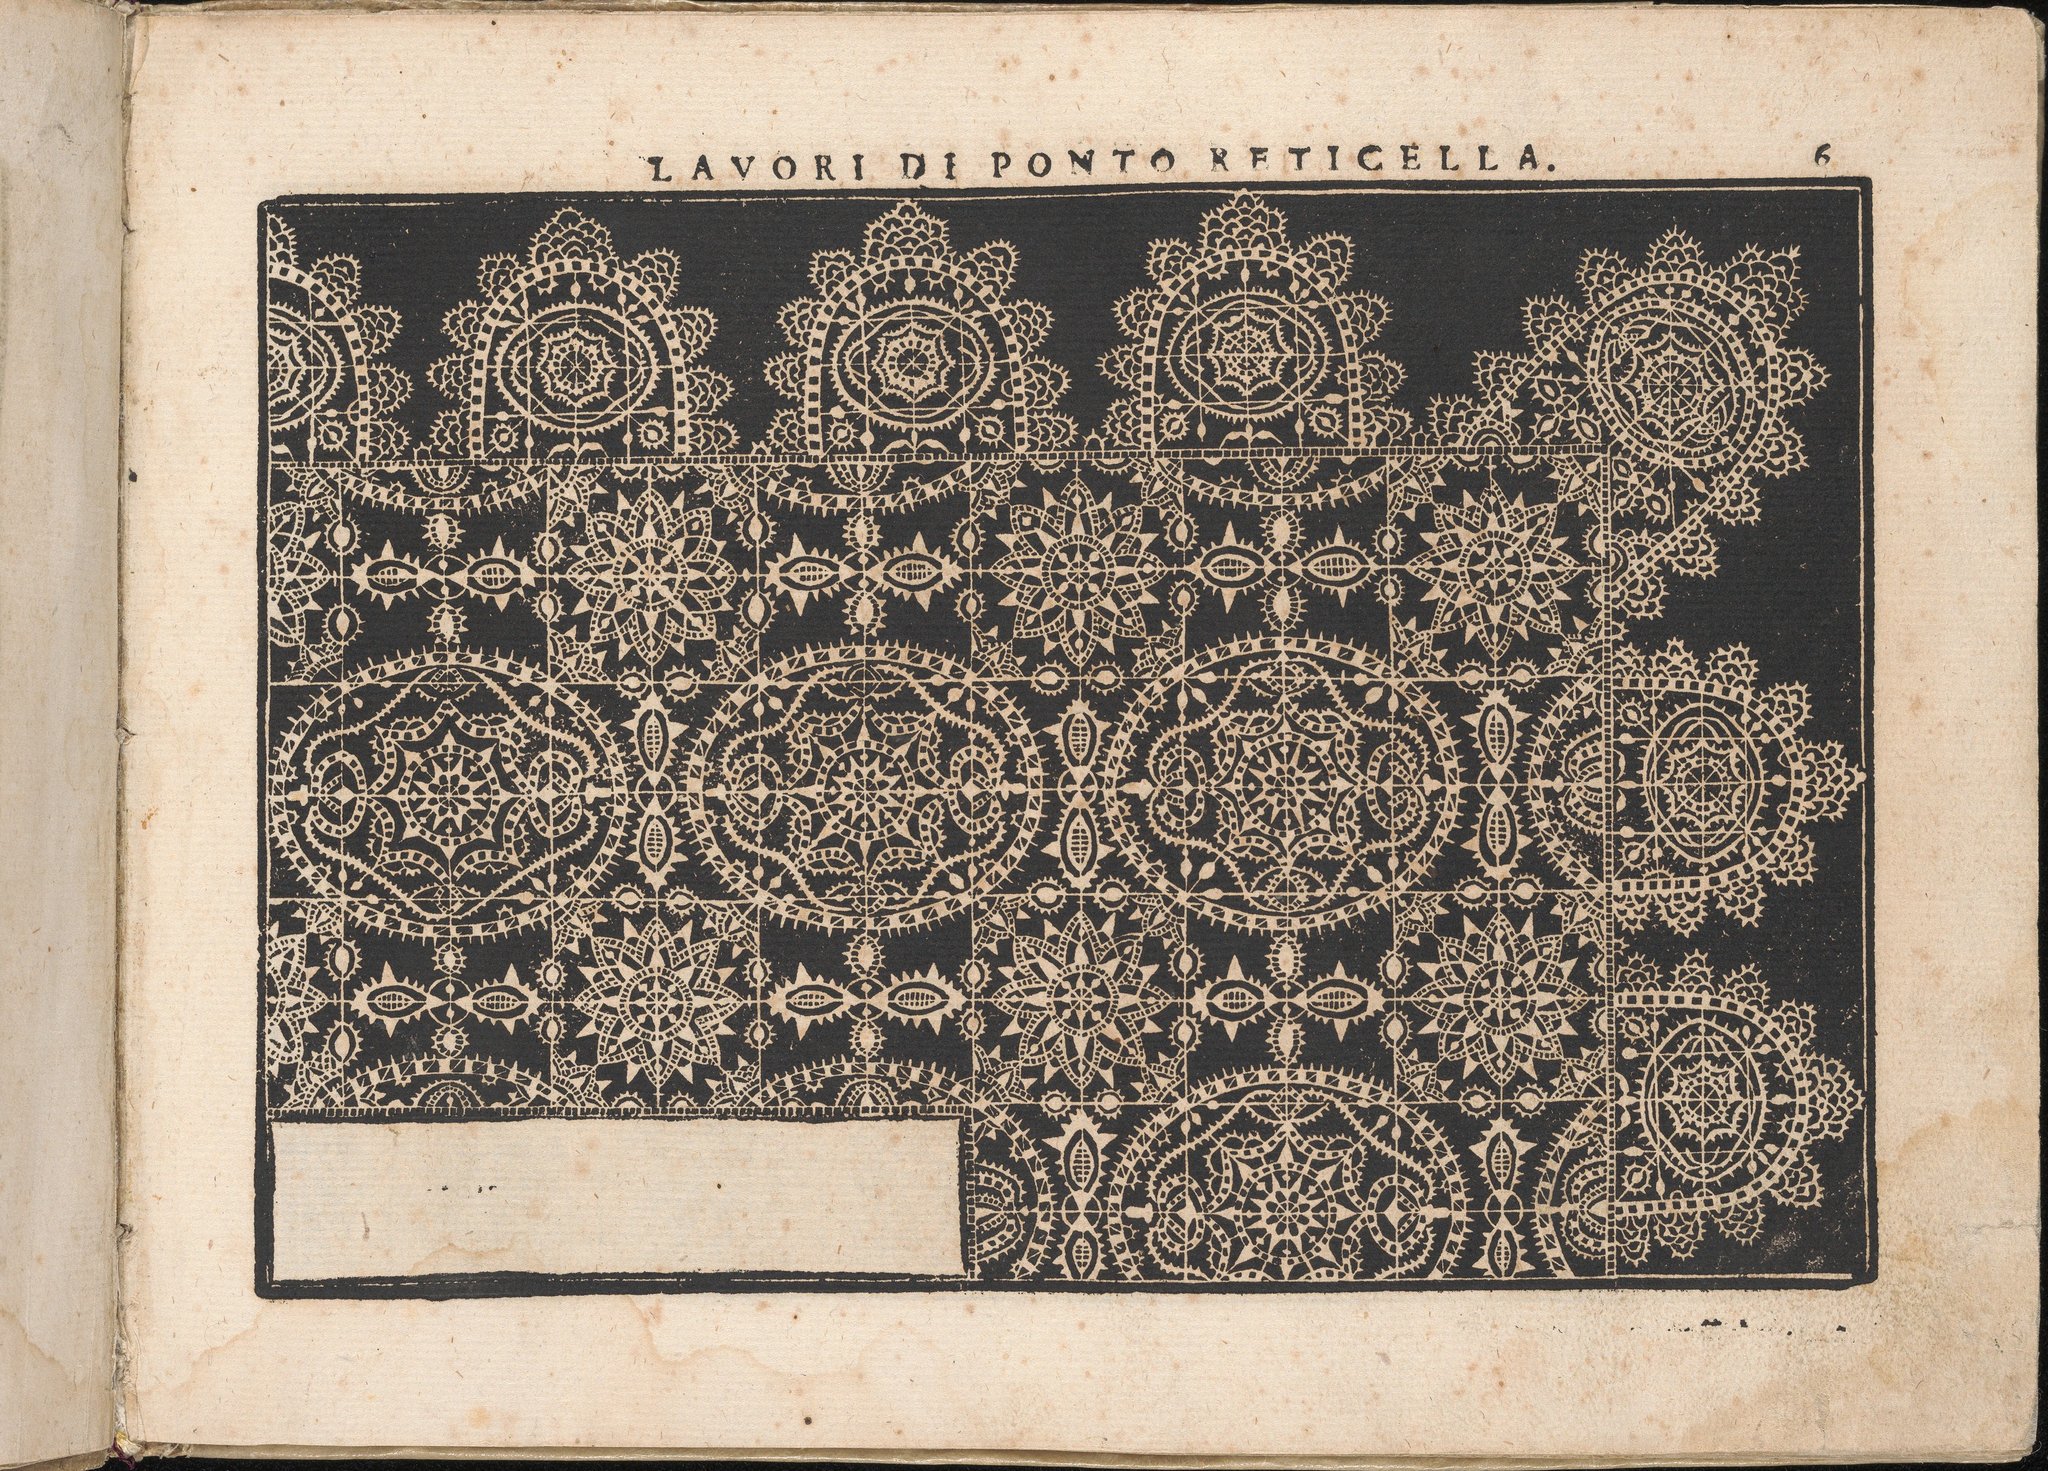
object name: book print ornament architecture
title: Fiore D'Ogni Virtu Per le Nobili Et Honeste Matrone, page 6 (recto)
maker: isabella catanea parasole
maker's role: designer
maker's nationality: italian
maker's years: 1565-1625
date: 1610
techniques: woodcut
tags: flowers